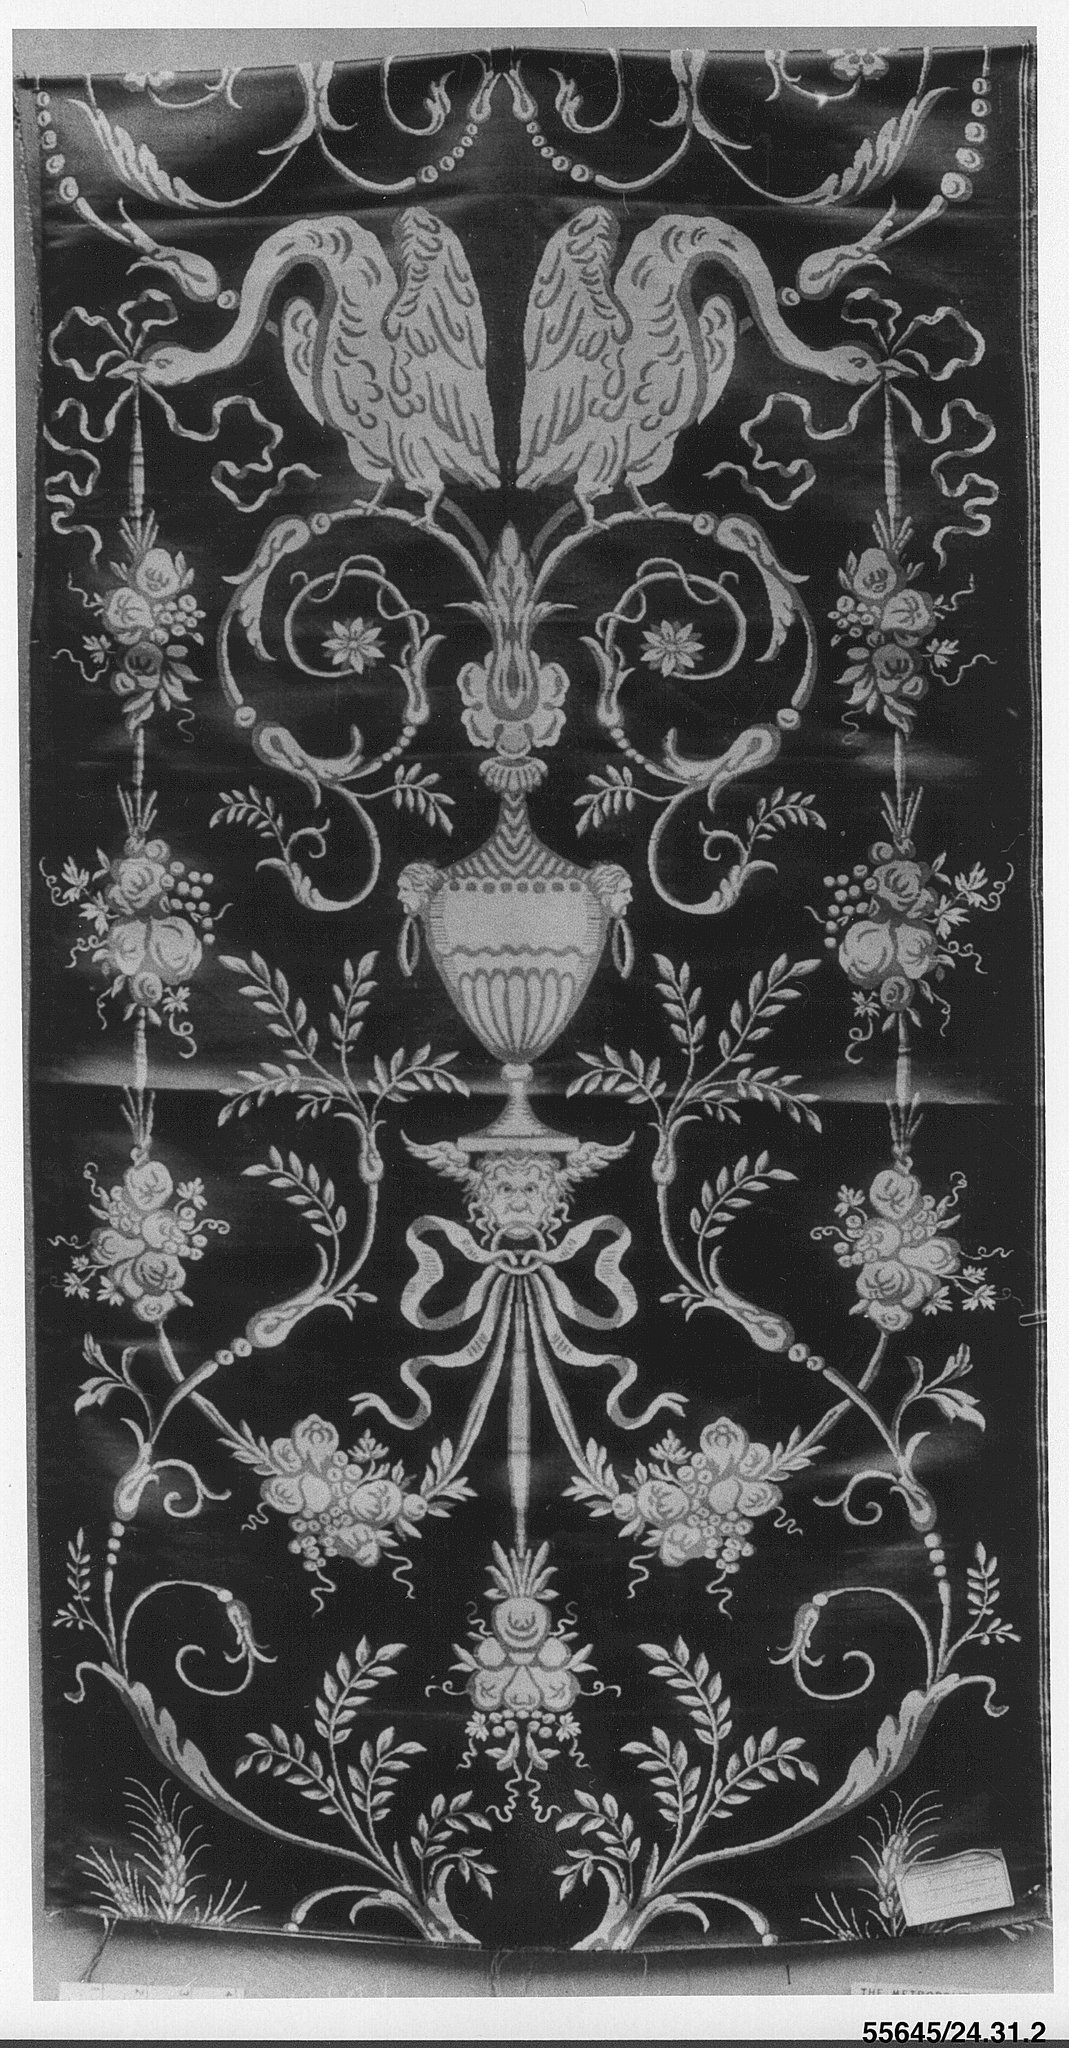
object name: length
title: Length of woven silk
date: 1830-1848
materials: silk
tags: birds,flowers